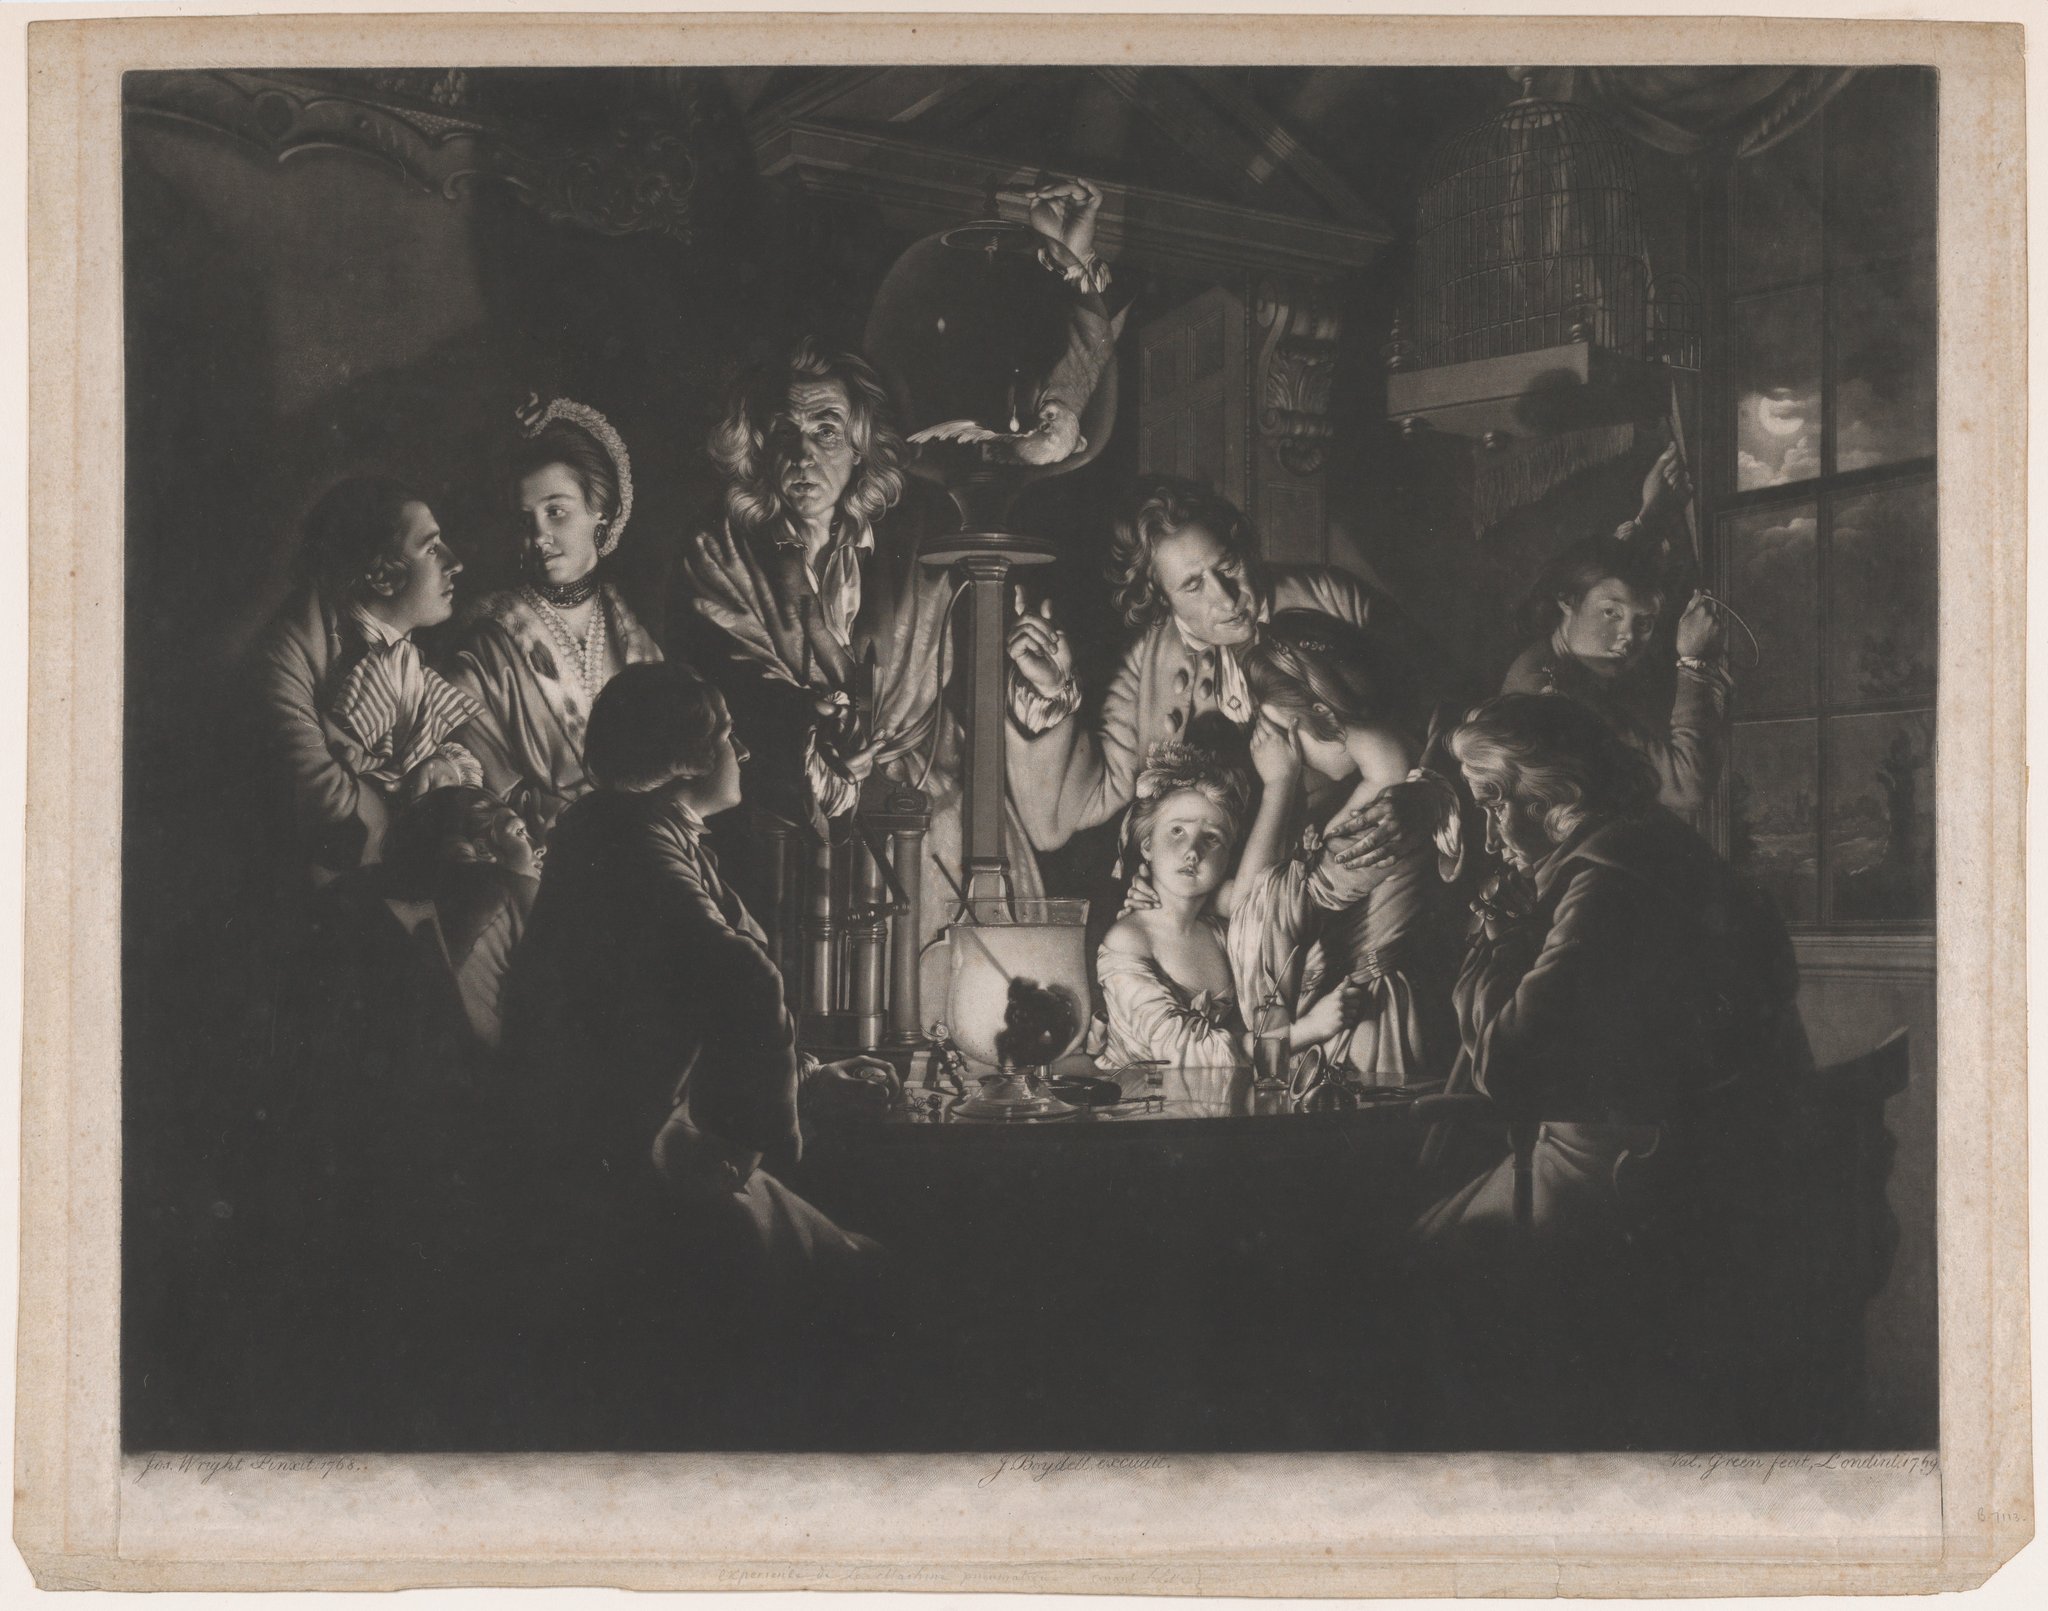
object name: print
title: A Philosopher Shewing an Experiment on the Air Pump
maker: valentine green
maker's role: engraver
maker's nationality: british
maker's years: 1739-1813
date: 1769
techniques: mezzotint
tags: science,birds,children,men,women